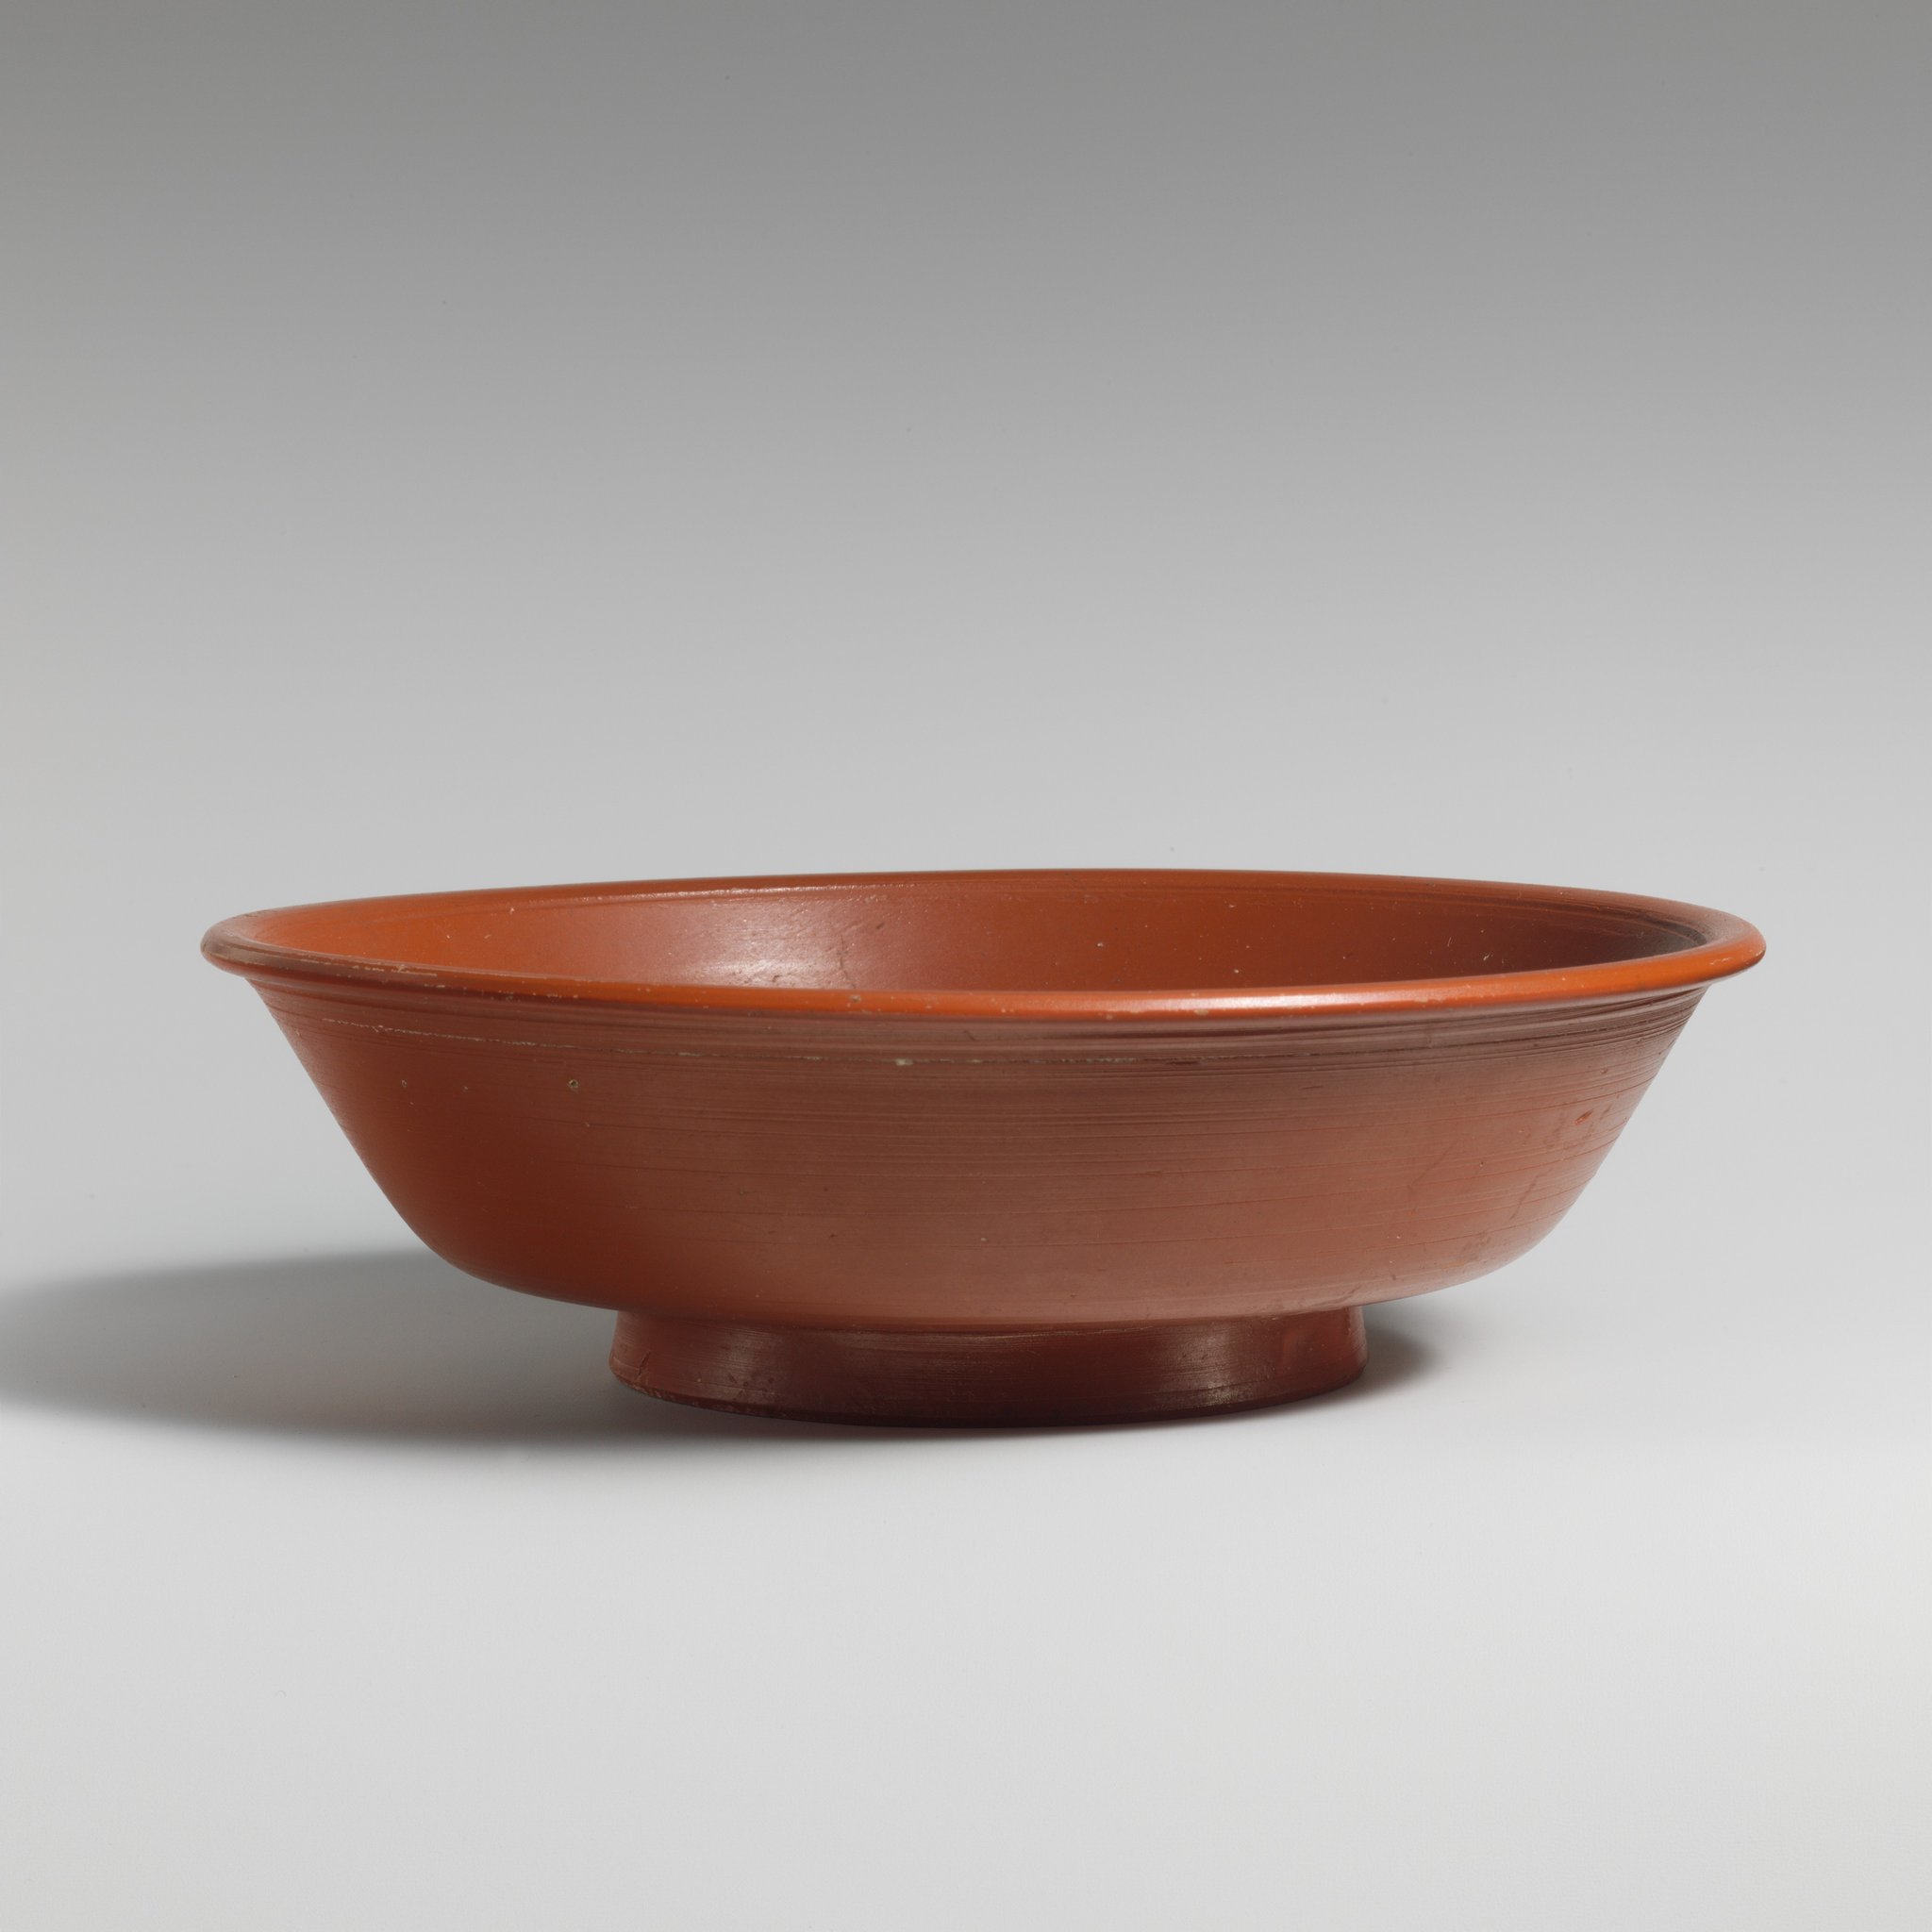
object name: bowl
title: Terracotta bowl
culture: roman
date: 10-50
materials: terracotta